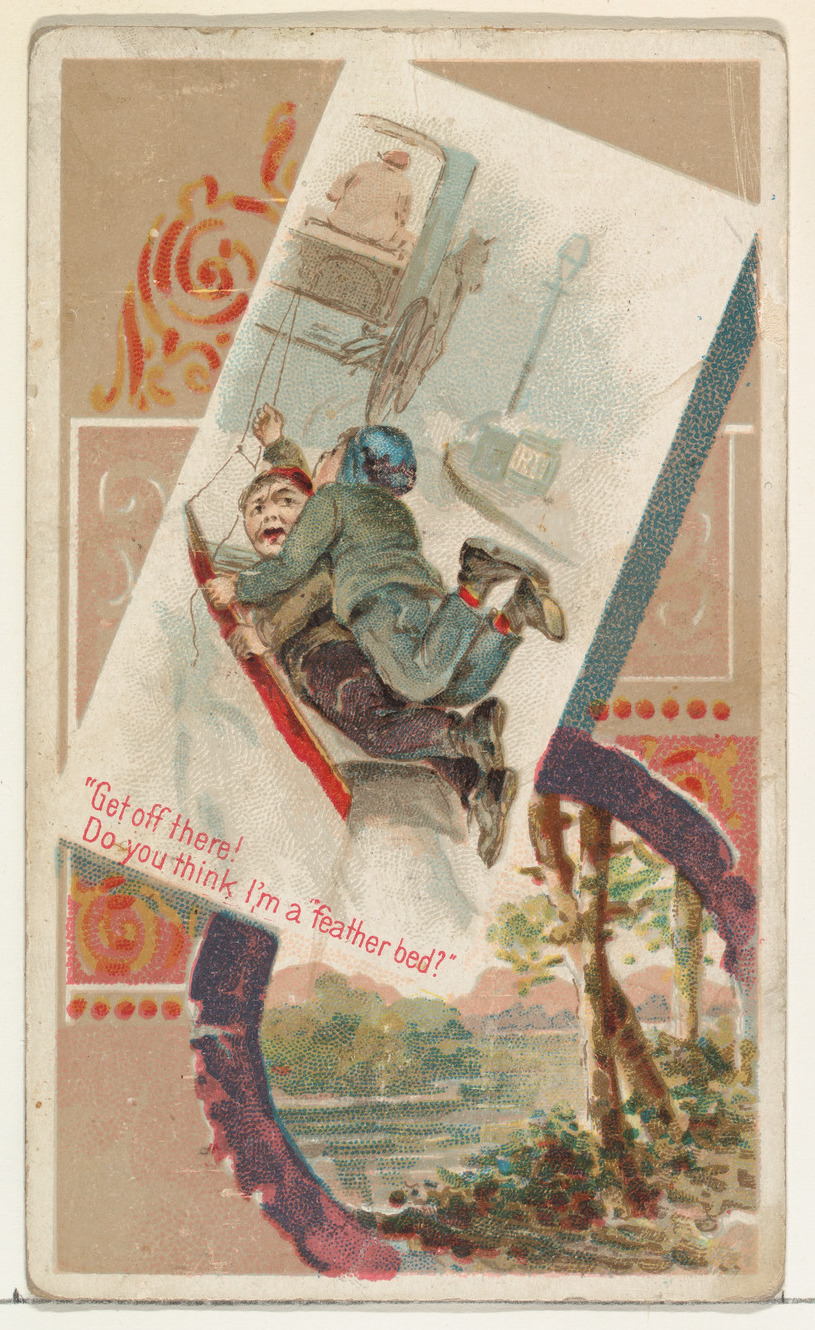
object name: print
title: "Get off there! Do you think I'm a feather bed?," from the Terrors of America set (N136) issued by Duke Sons & Co. to promote Honest Long Cut Tobacco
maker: w. duke, sons & co.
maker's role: publisher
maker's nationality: american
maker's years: 1870-1920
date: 1888-1889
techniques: color lithograph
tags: boys